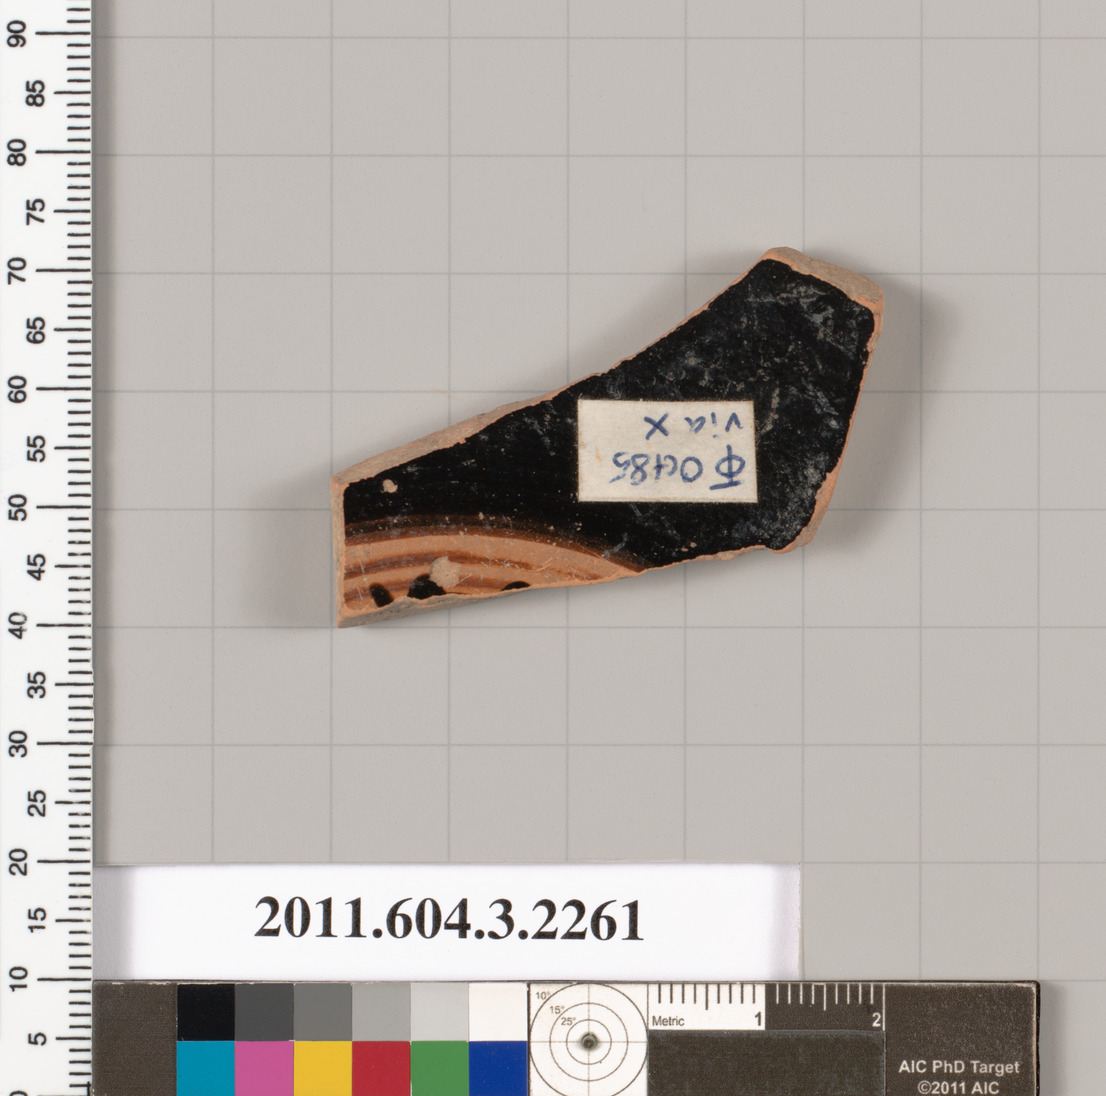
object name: kylix fragment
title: Terracotta fragment of a kylix (drinking cup)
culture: greek, attic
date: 600-401 BCE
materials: terracotta